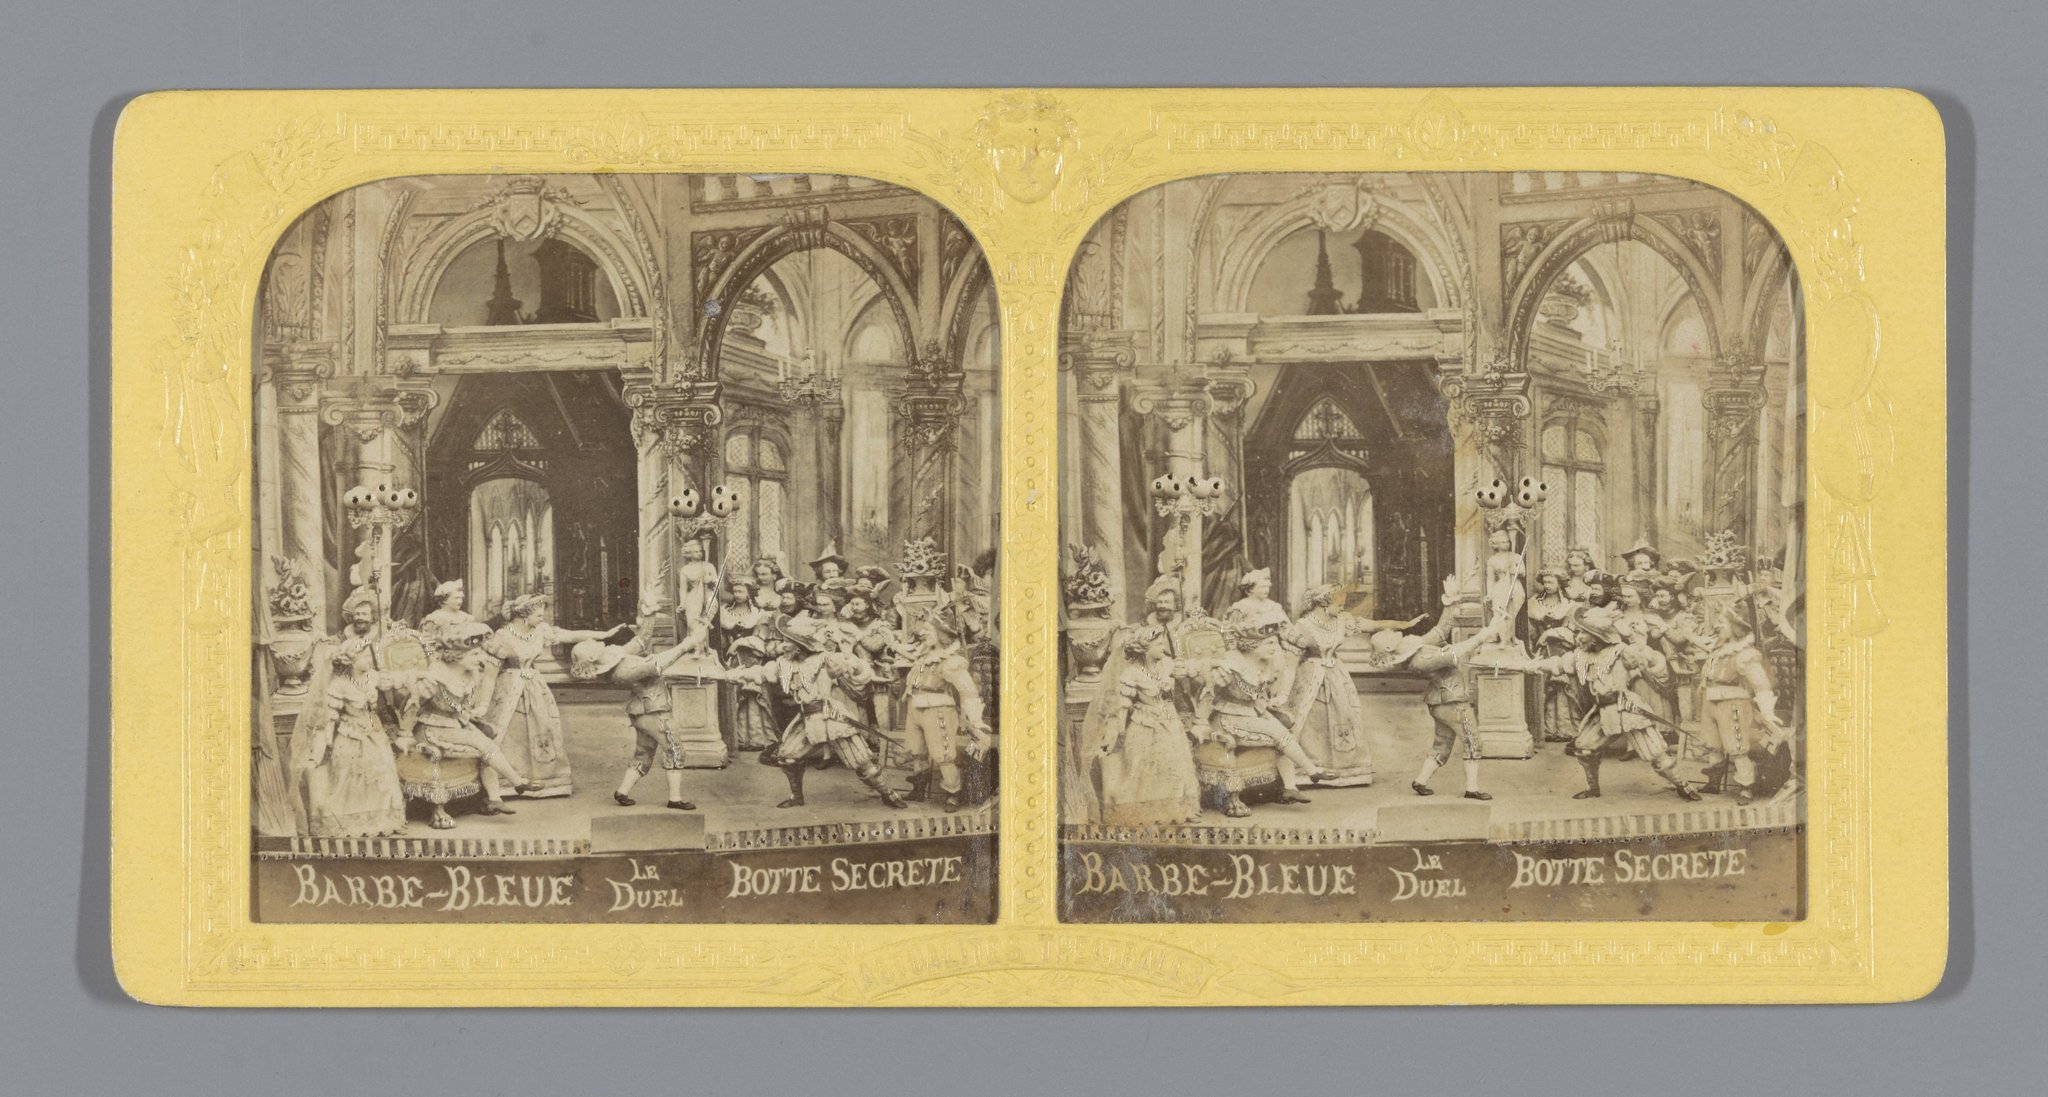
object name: stereograph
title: Barbe bleue le duel botte secrete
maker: Anonymous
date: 1867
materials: cardboard, photographic support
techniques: albumen print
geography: paris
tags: group of actors, troupe; actors on the stage, paris